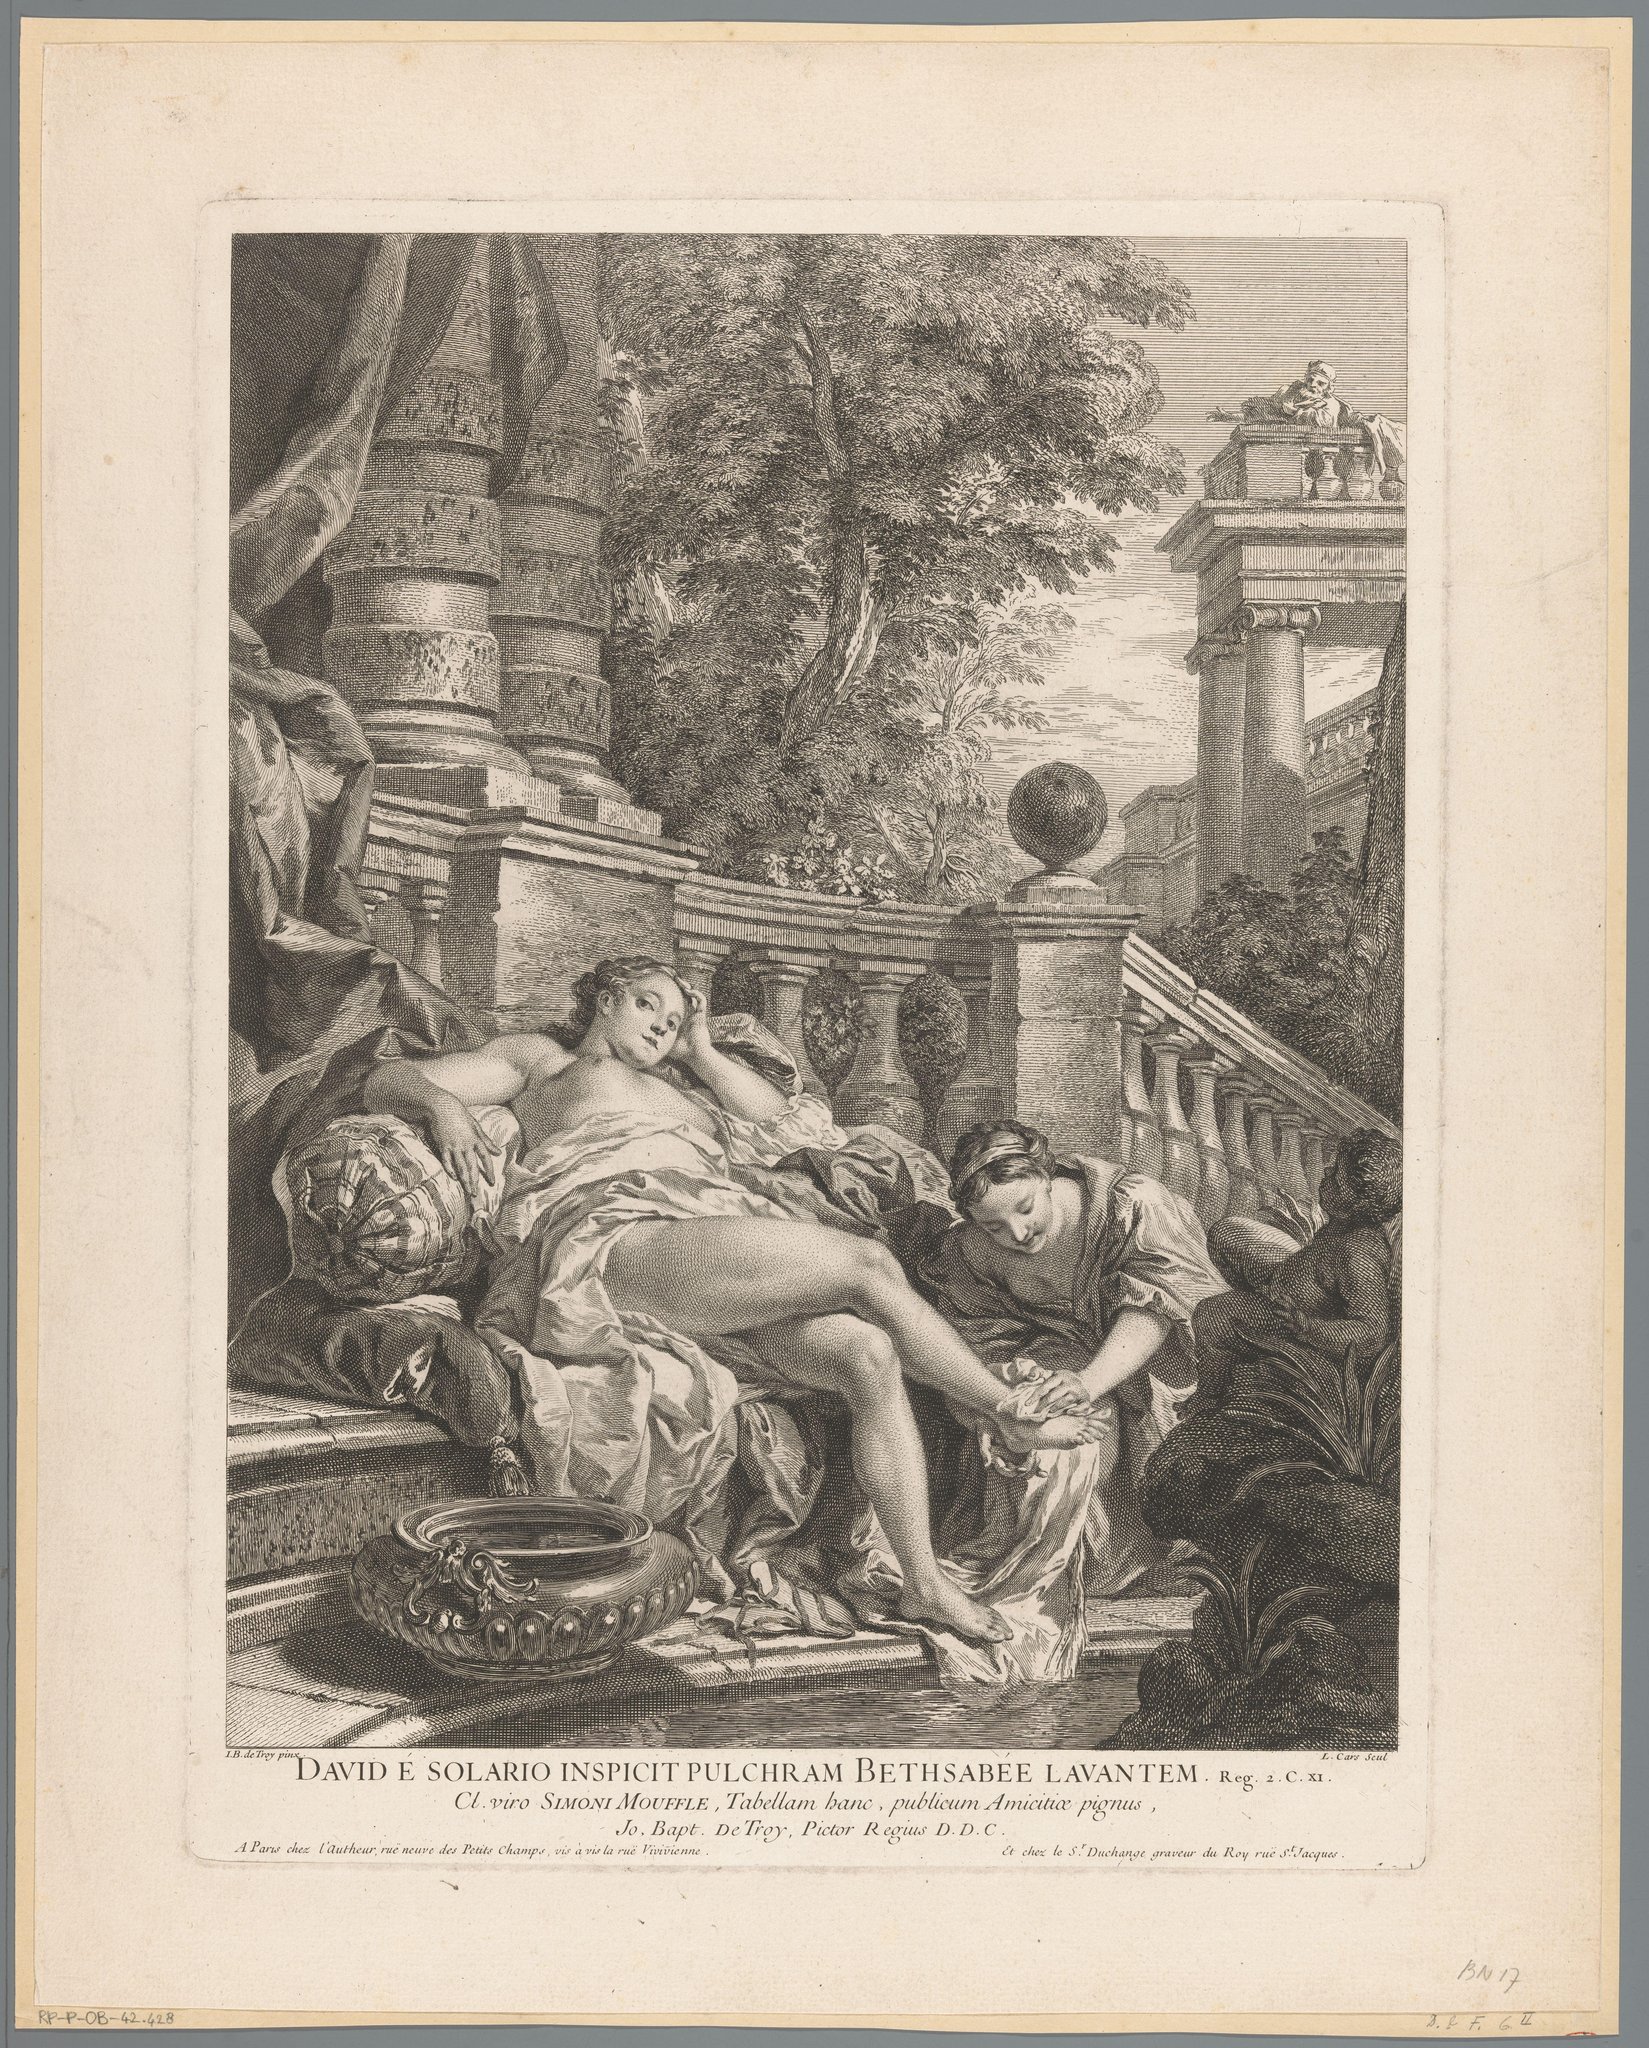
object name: print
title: Badende Bathseba bespied door David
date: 1729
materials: paper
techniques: engraving, etching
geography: paris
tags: david, from the roof (or balcony) of his palace, sees bathsheba bathing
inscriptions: collector's mark: Lugt 240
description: Het schilderij door De Troy werd in 1727 vervaardigd en bevindt zich in het Musée des beaux-arts d'Angers.